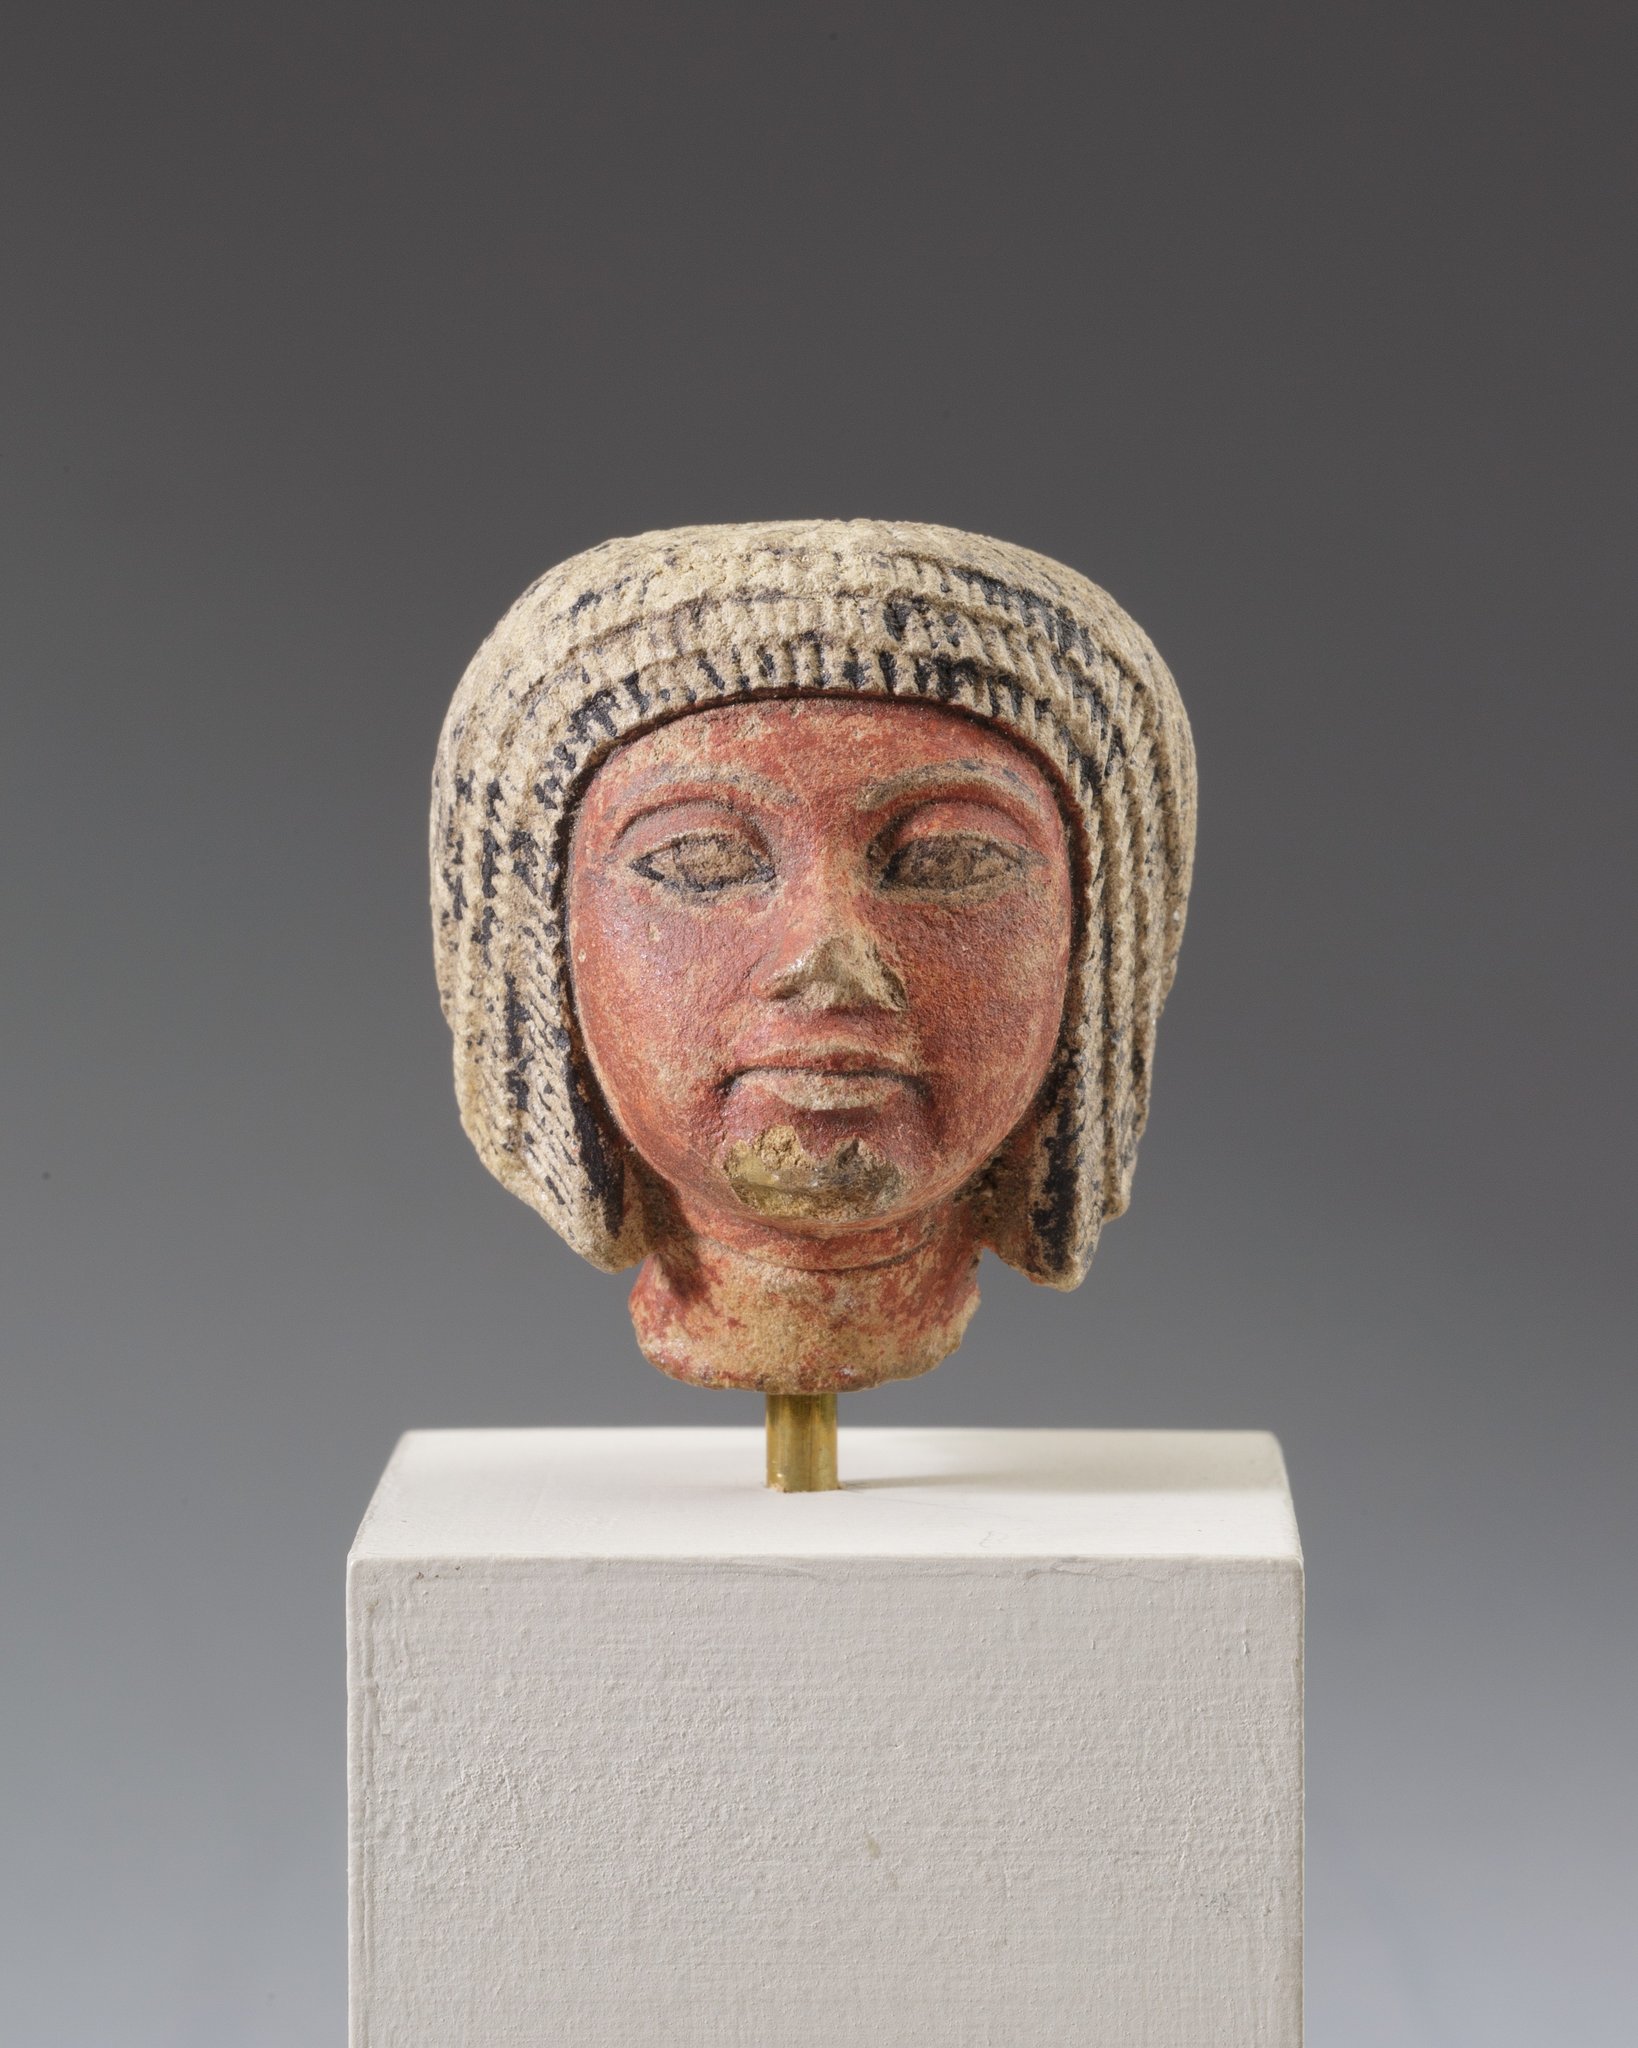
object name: head, statuette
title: Head from a statuette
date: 1353-1336 BCE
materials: limestone, paint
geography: egypt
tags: heads